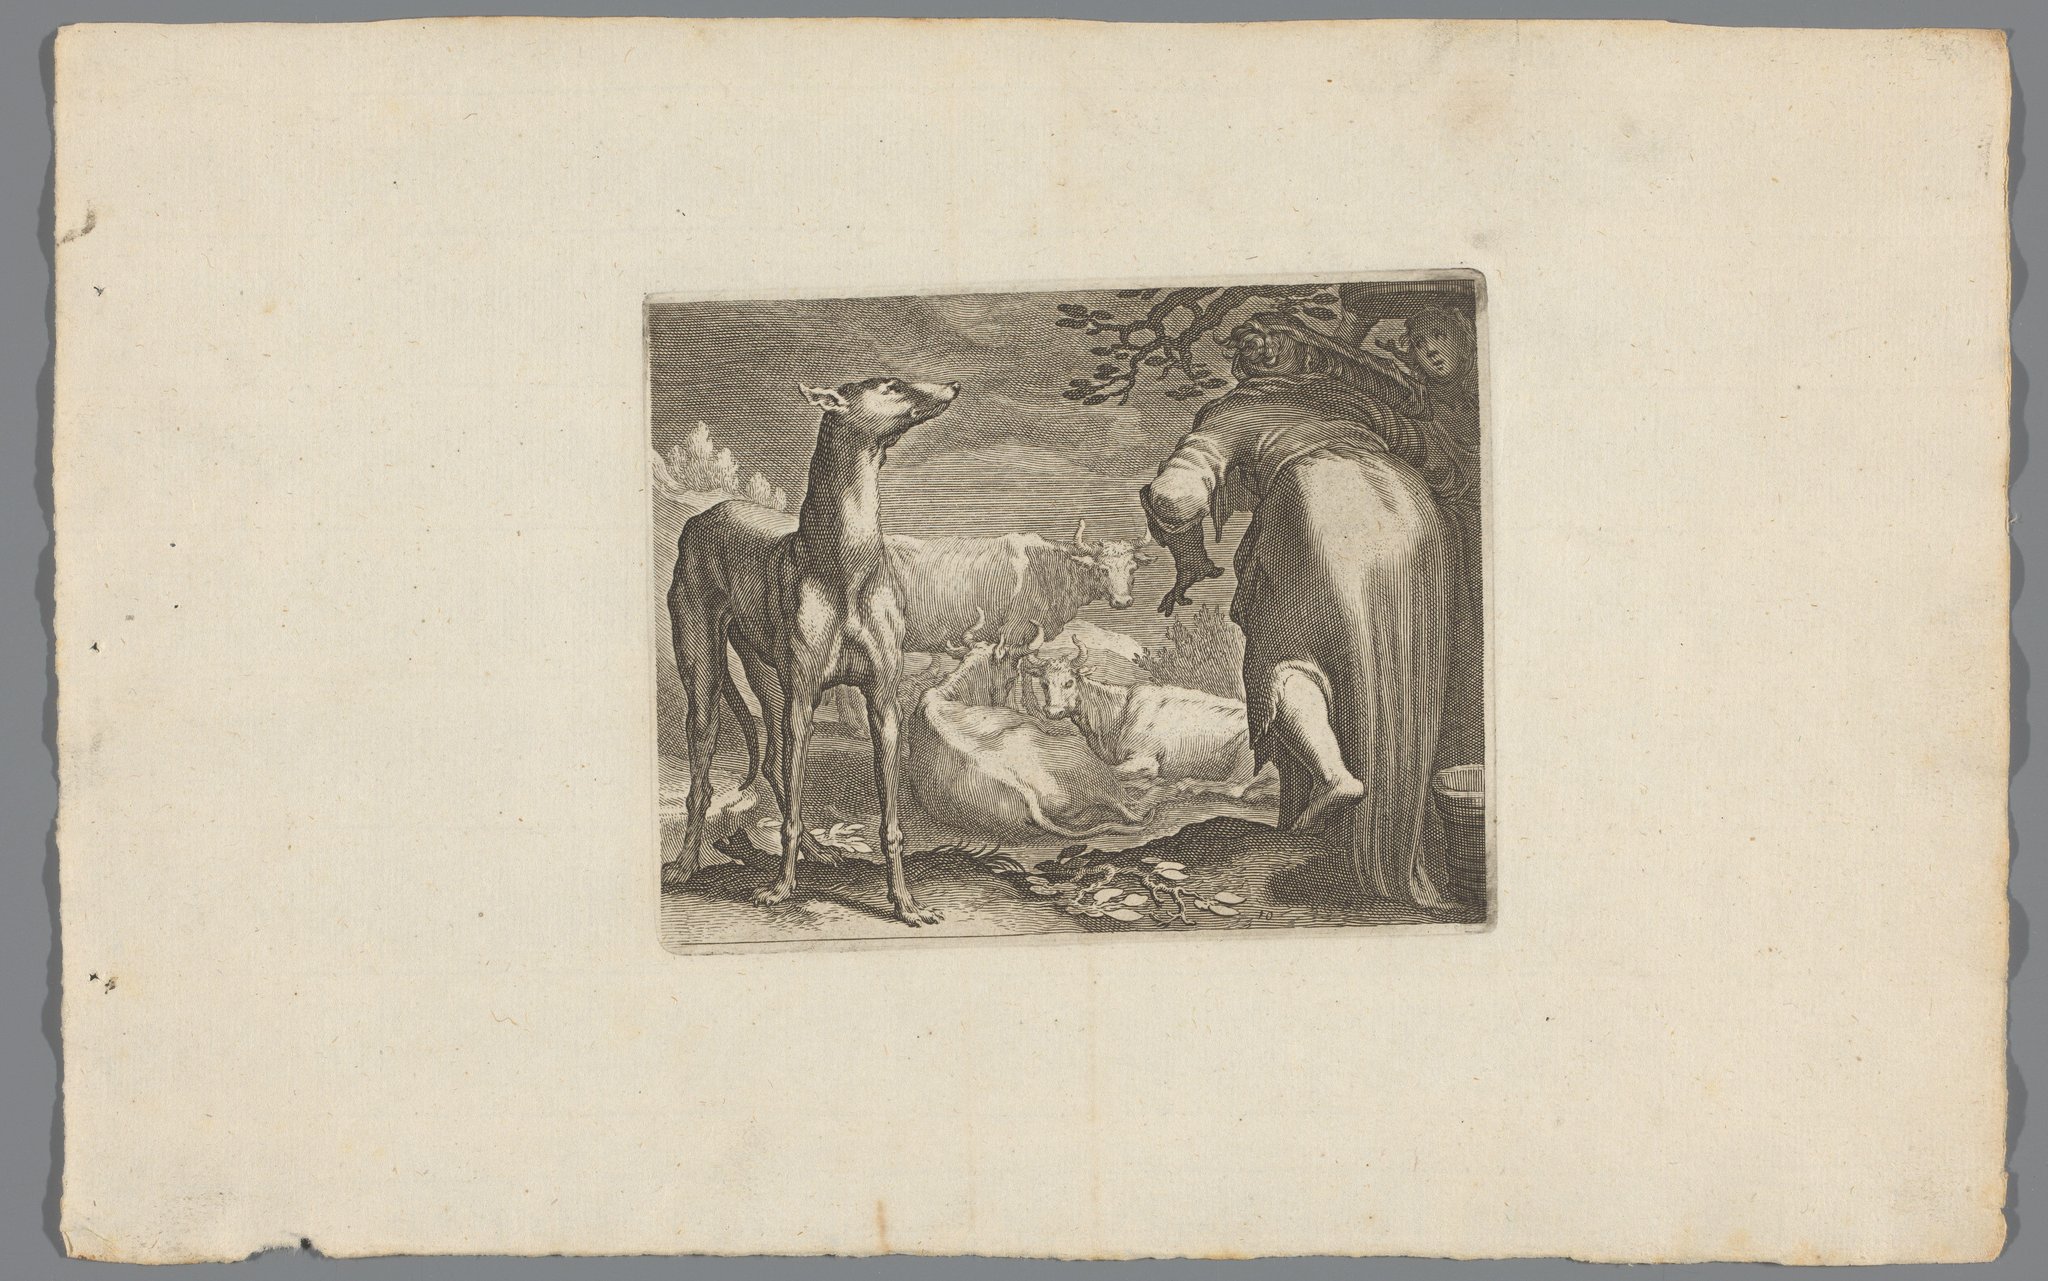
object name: print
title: Twee vrouwen en hond bij koeien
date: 1611-1632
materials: paper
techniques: engraving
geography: amsterdam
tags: cow, milkmaid, dog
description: Prent maakt deel uit van een serie van veertien prenten.